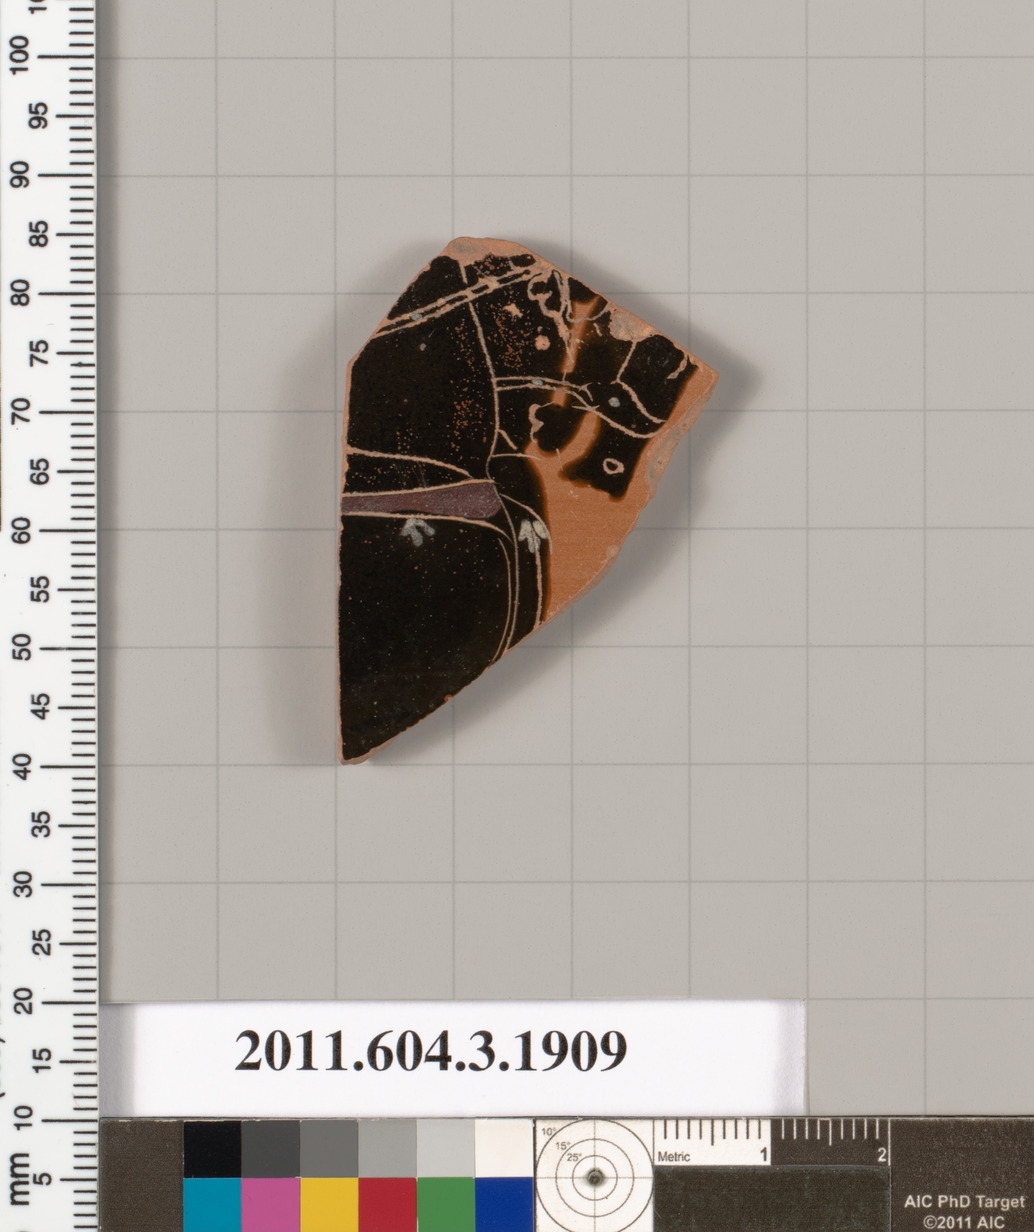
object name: kylix or skyphos fragment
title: Terracotta fragment of a kylix (drinking cup) or a skyphos (deep drinking cup)?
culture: greek, attic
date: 550-501 BCE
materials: terracotta